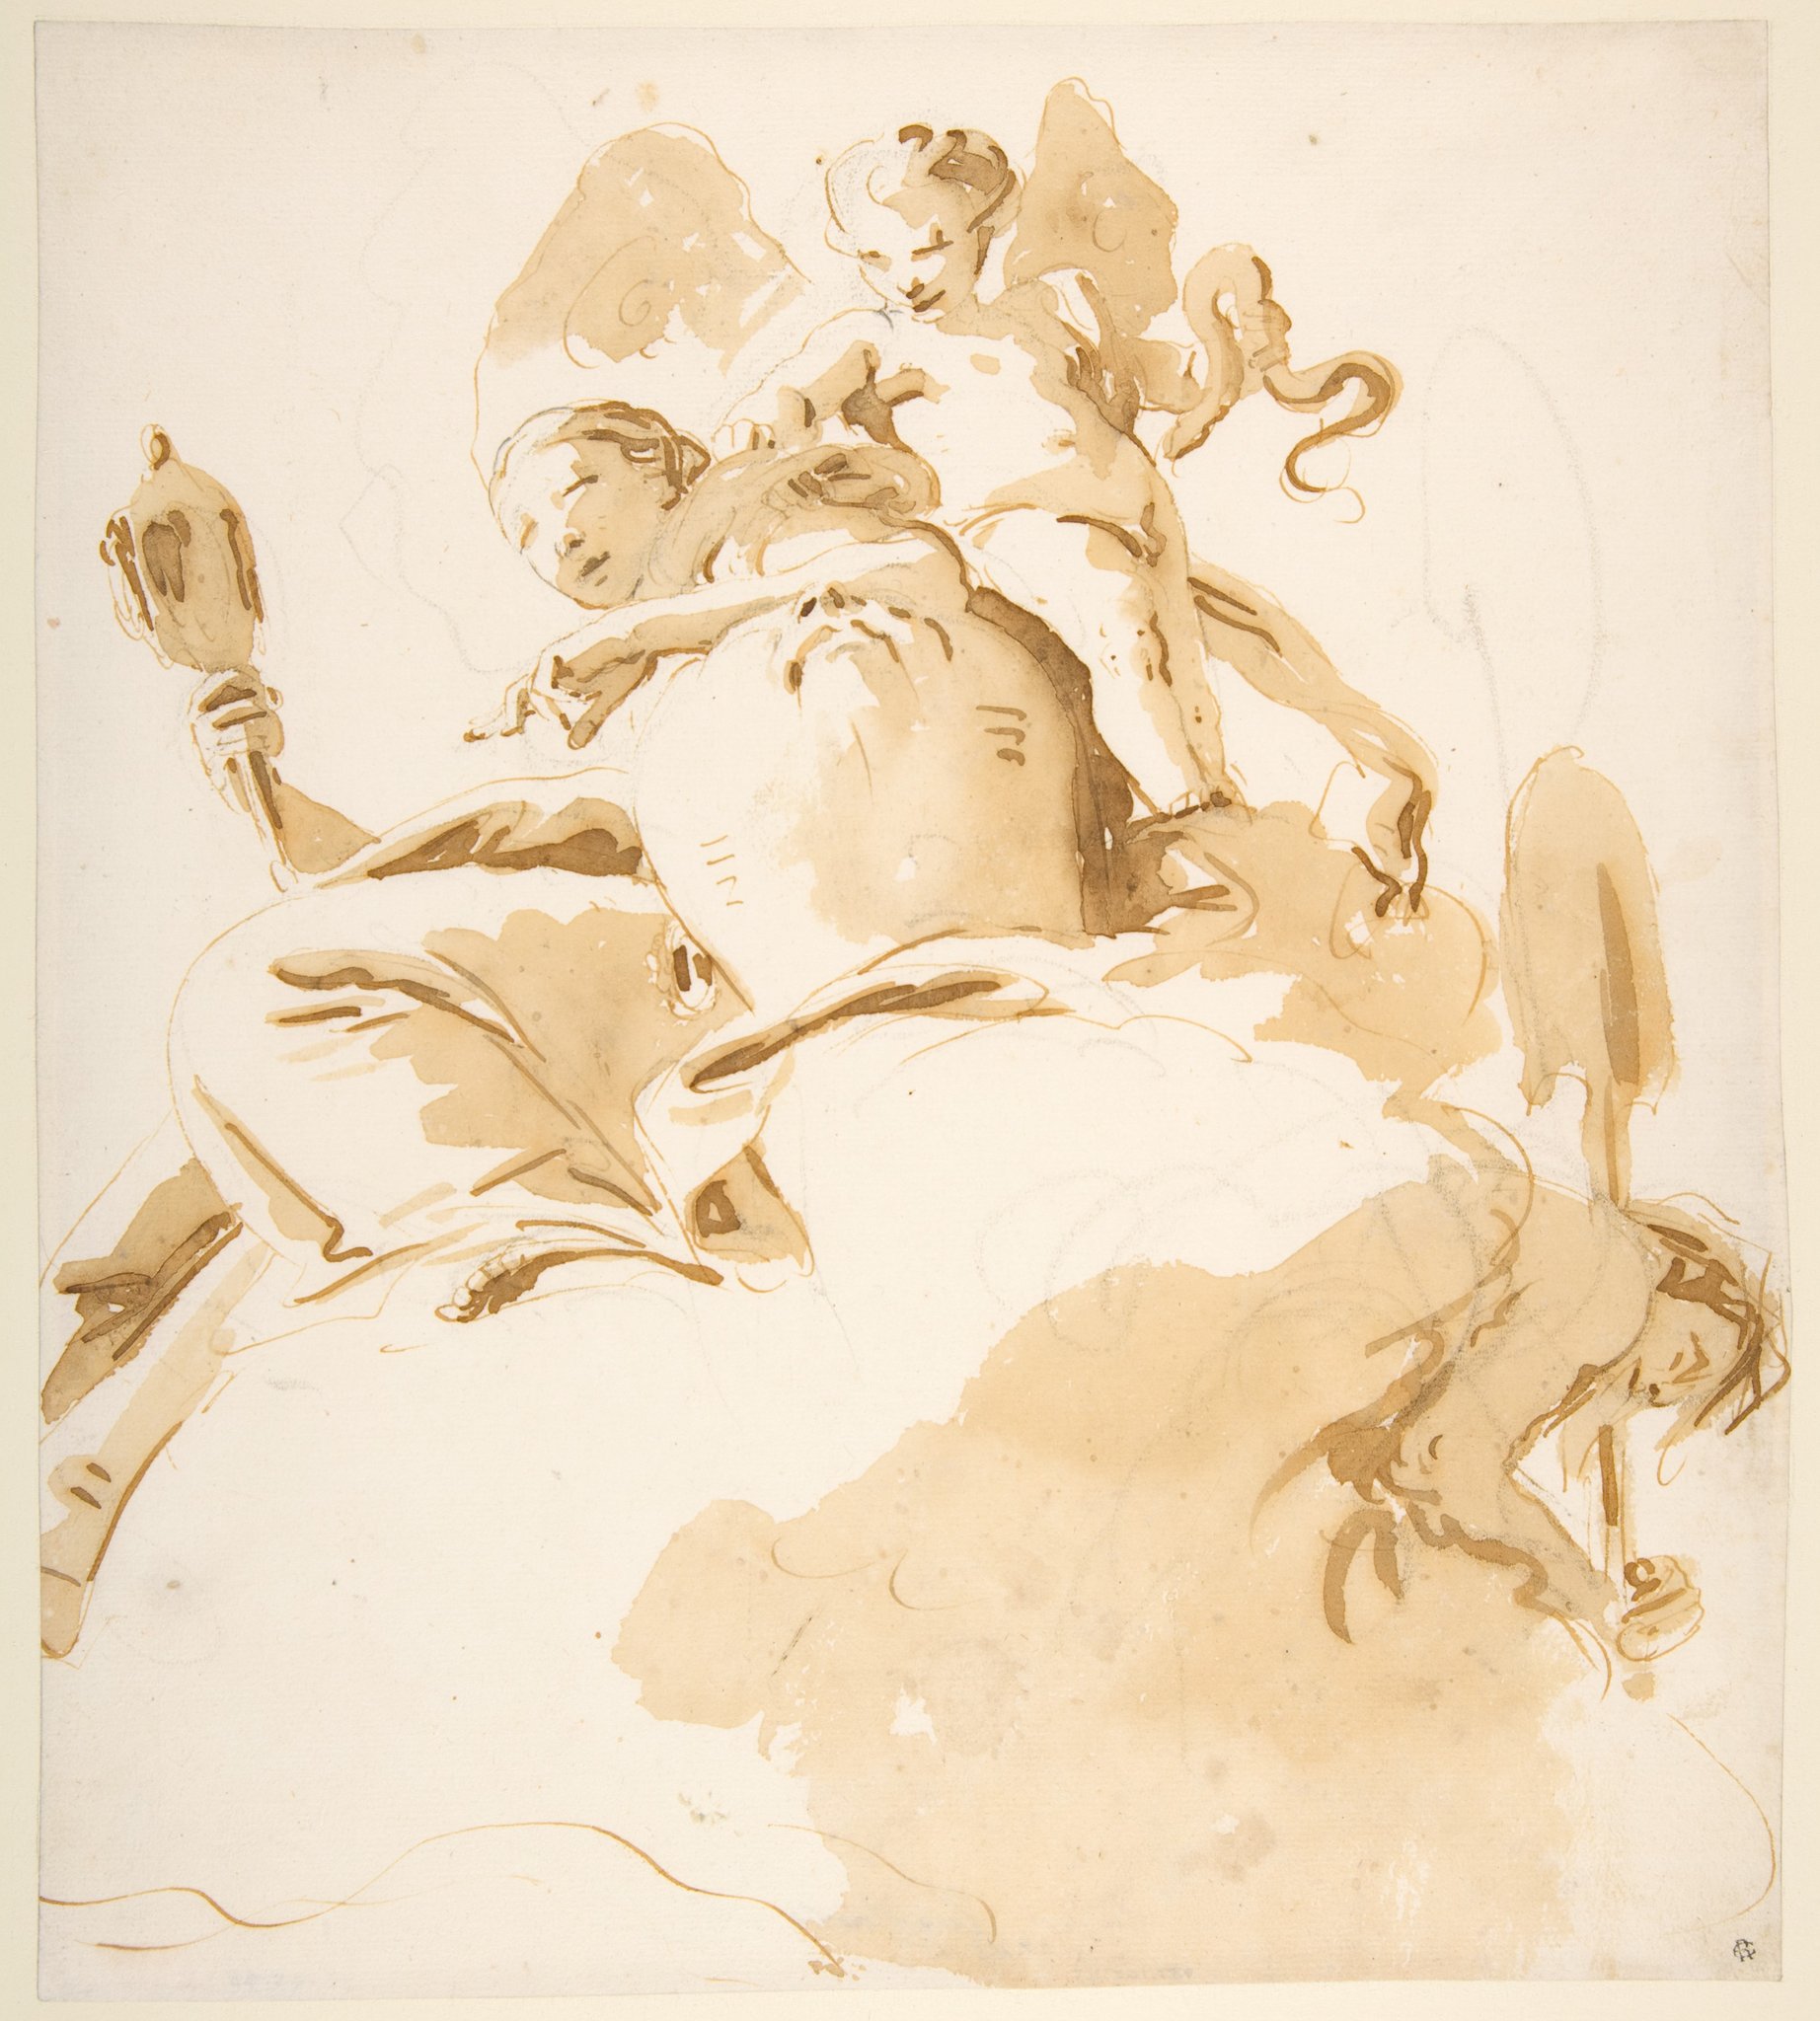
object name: drawing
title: Seated Woman with a Winged Putto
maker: giovanni battista tiepolo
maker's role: artist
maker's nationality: italian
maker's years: 1696-1770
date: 1696-1770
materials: chalk, ink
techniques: brush, pen, wash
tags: women